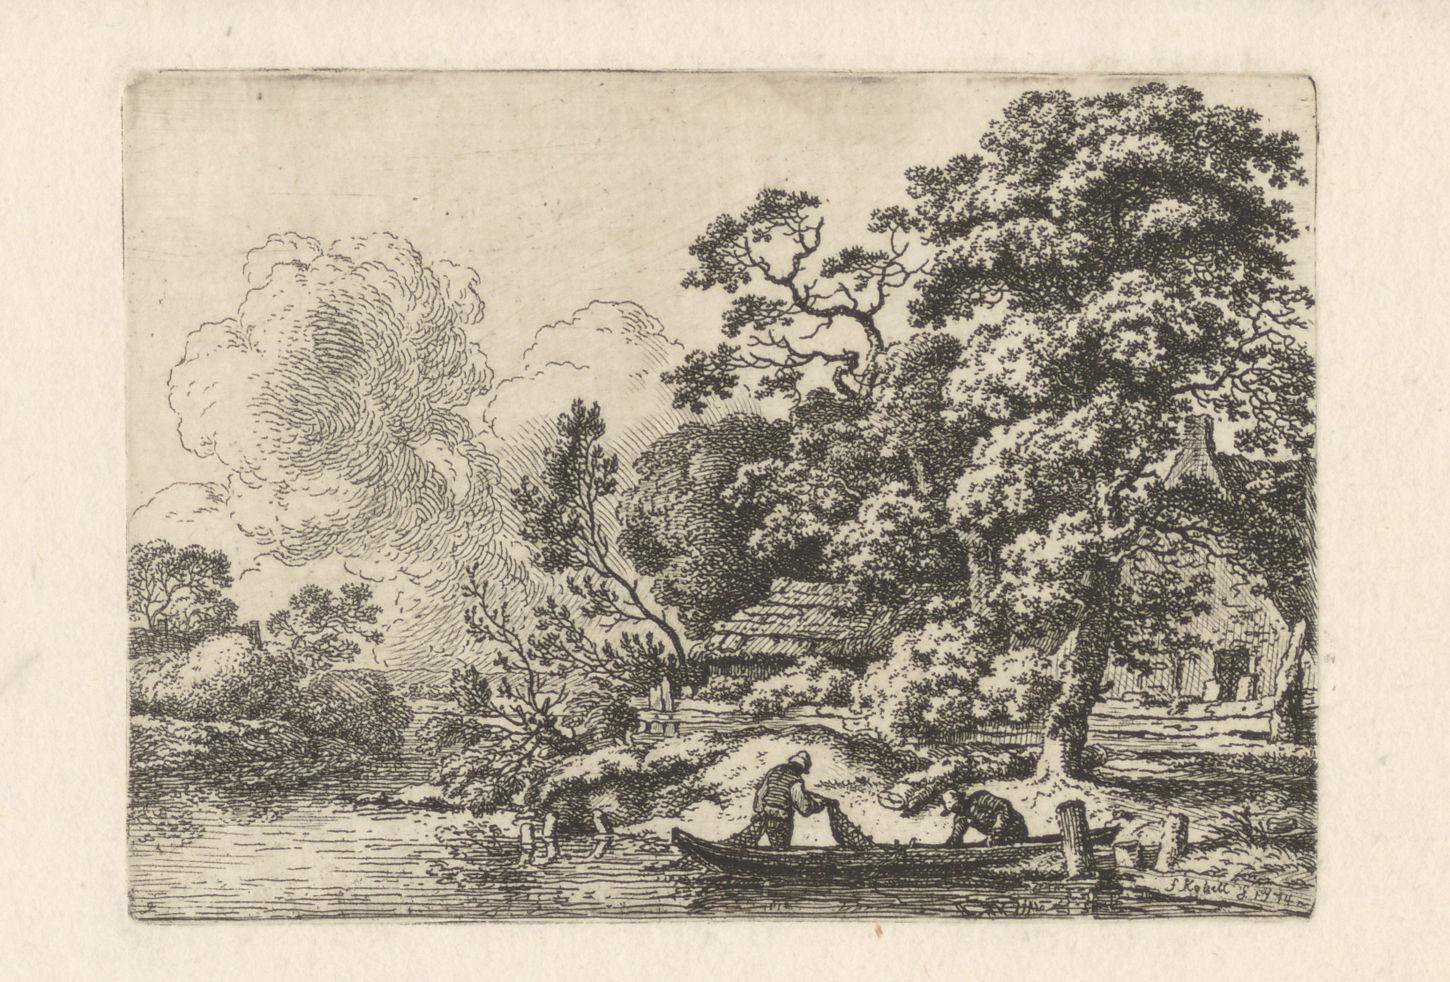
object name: print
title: Landschap met vissers bij de oever van een rivier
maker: ferdinand kobell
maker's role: artist, painter, print maker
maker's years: 1740-1799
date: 1774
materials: paper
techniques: etching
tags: brook, fisherman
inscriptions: date